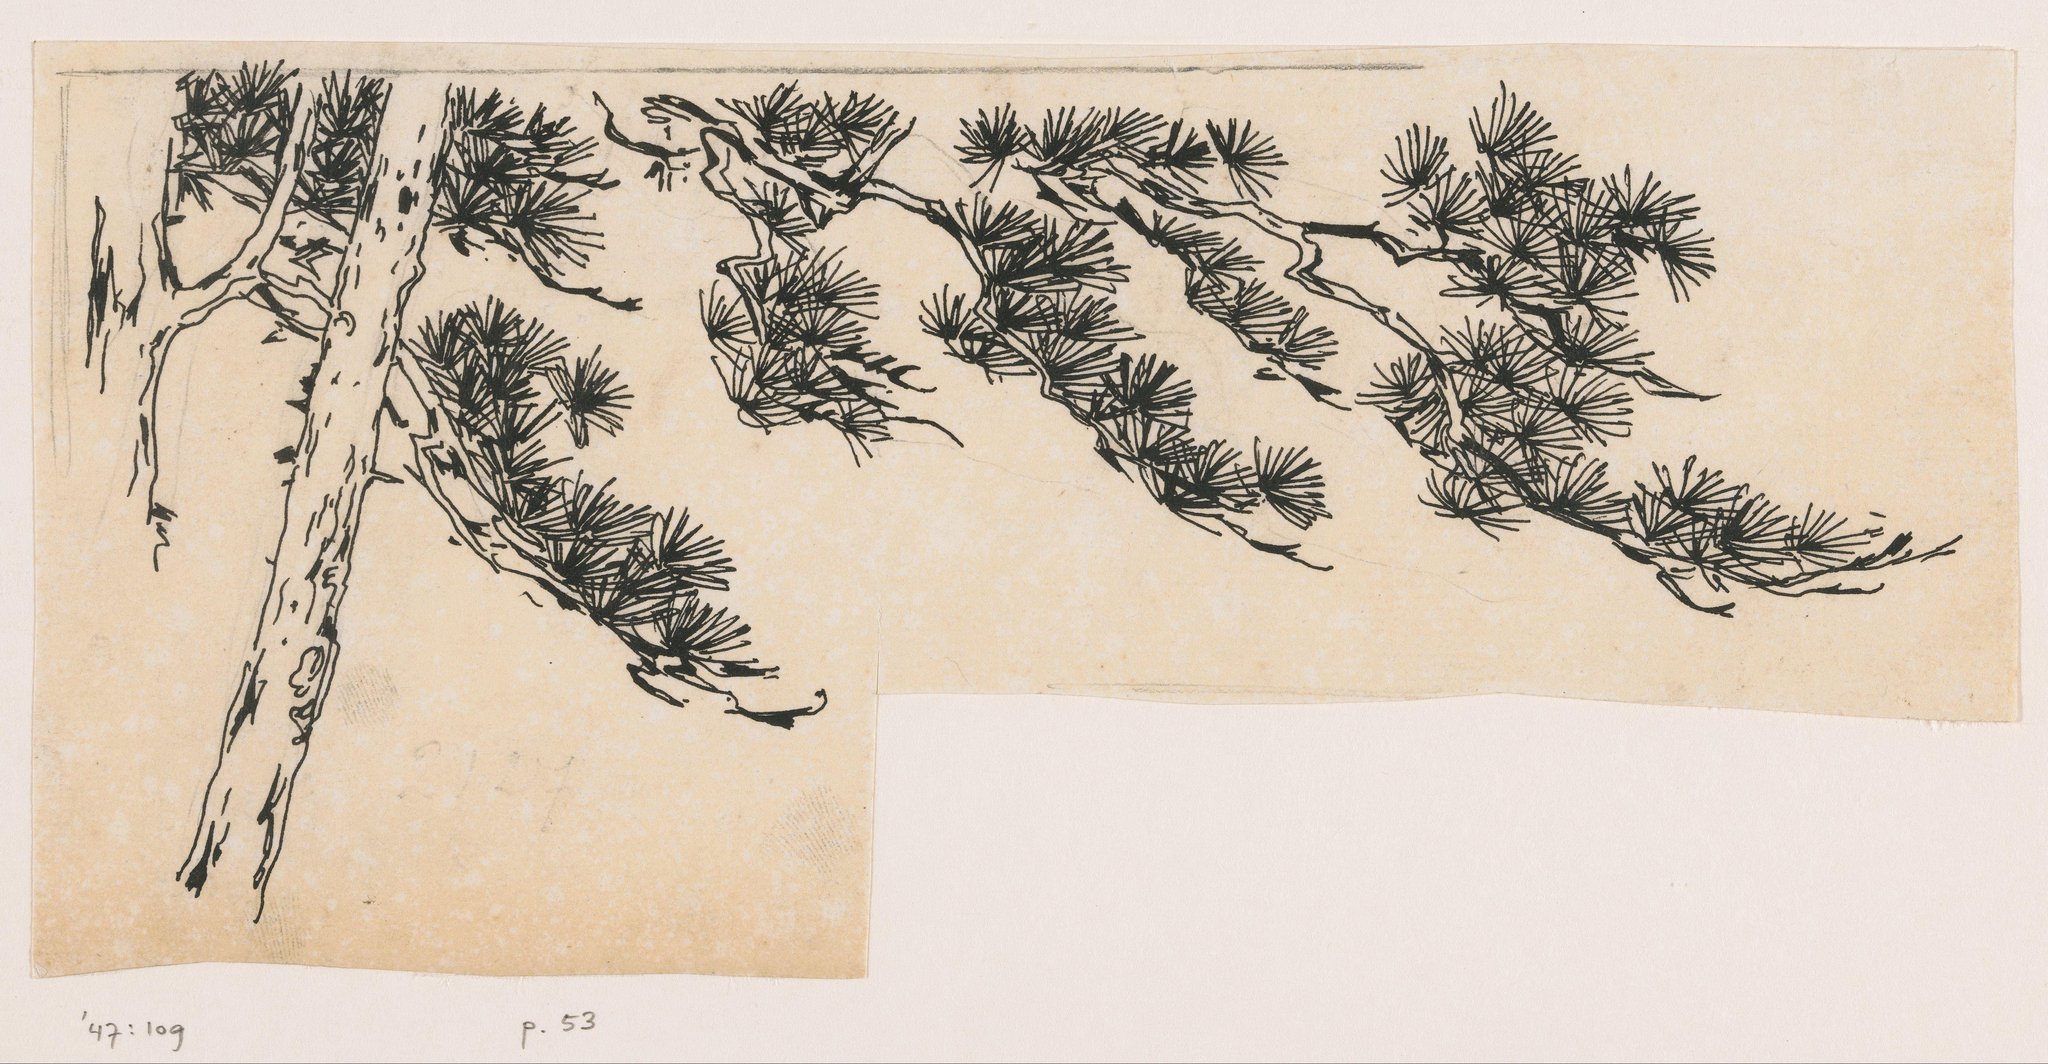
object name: drawing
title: Takken van een spar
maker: willem wenckebach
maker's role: designer, draughtsman, painter, print maker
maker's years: 1860-1937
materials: ink, paper, pencil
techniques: pen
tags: trees: fir (branch, stick)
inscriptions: :, collector's mark: Lugt 2228a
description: Ontwerp voor: Knappert, Emilie C. Kijkjes in de plantenwereld. Loman & Funke: Amsterdam, 1893. In de verklarende naamlijst achterin wordt verwezen naar 'sparregroen'.